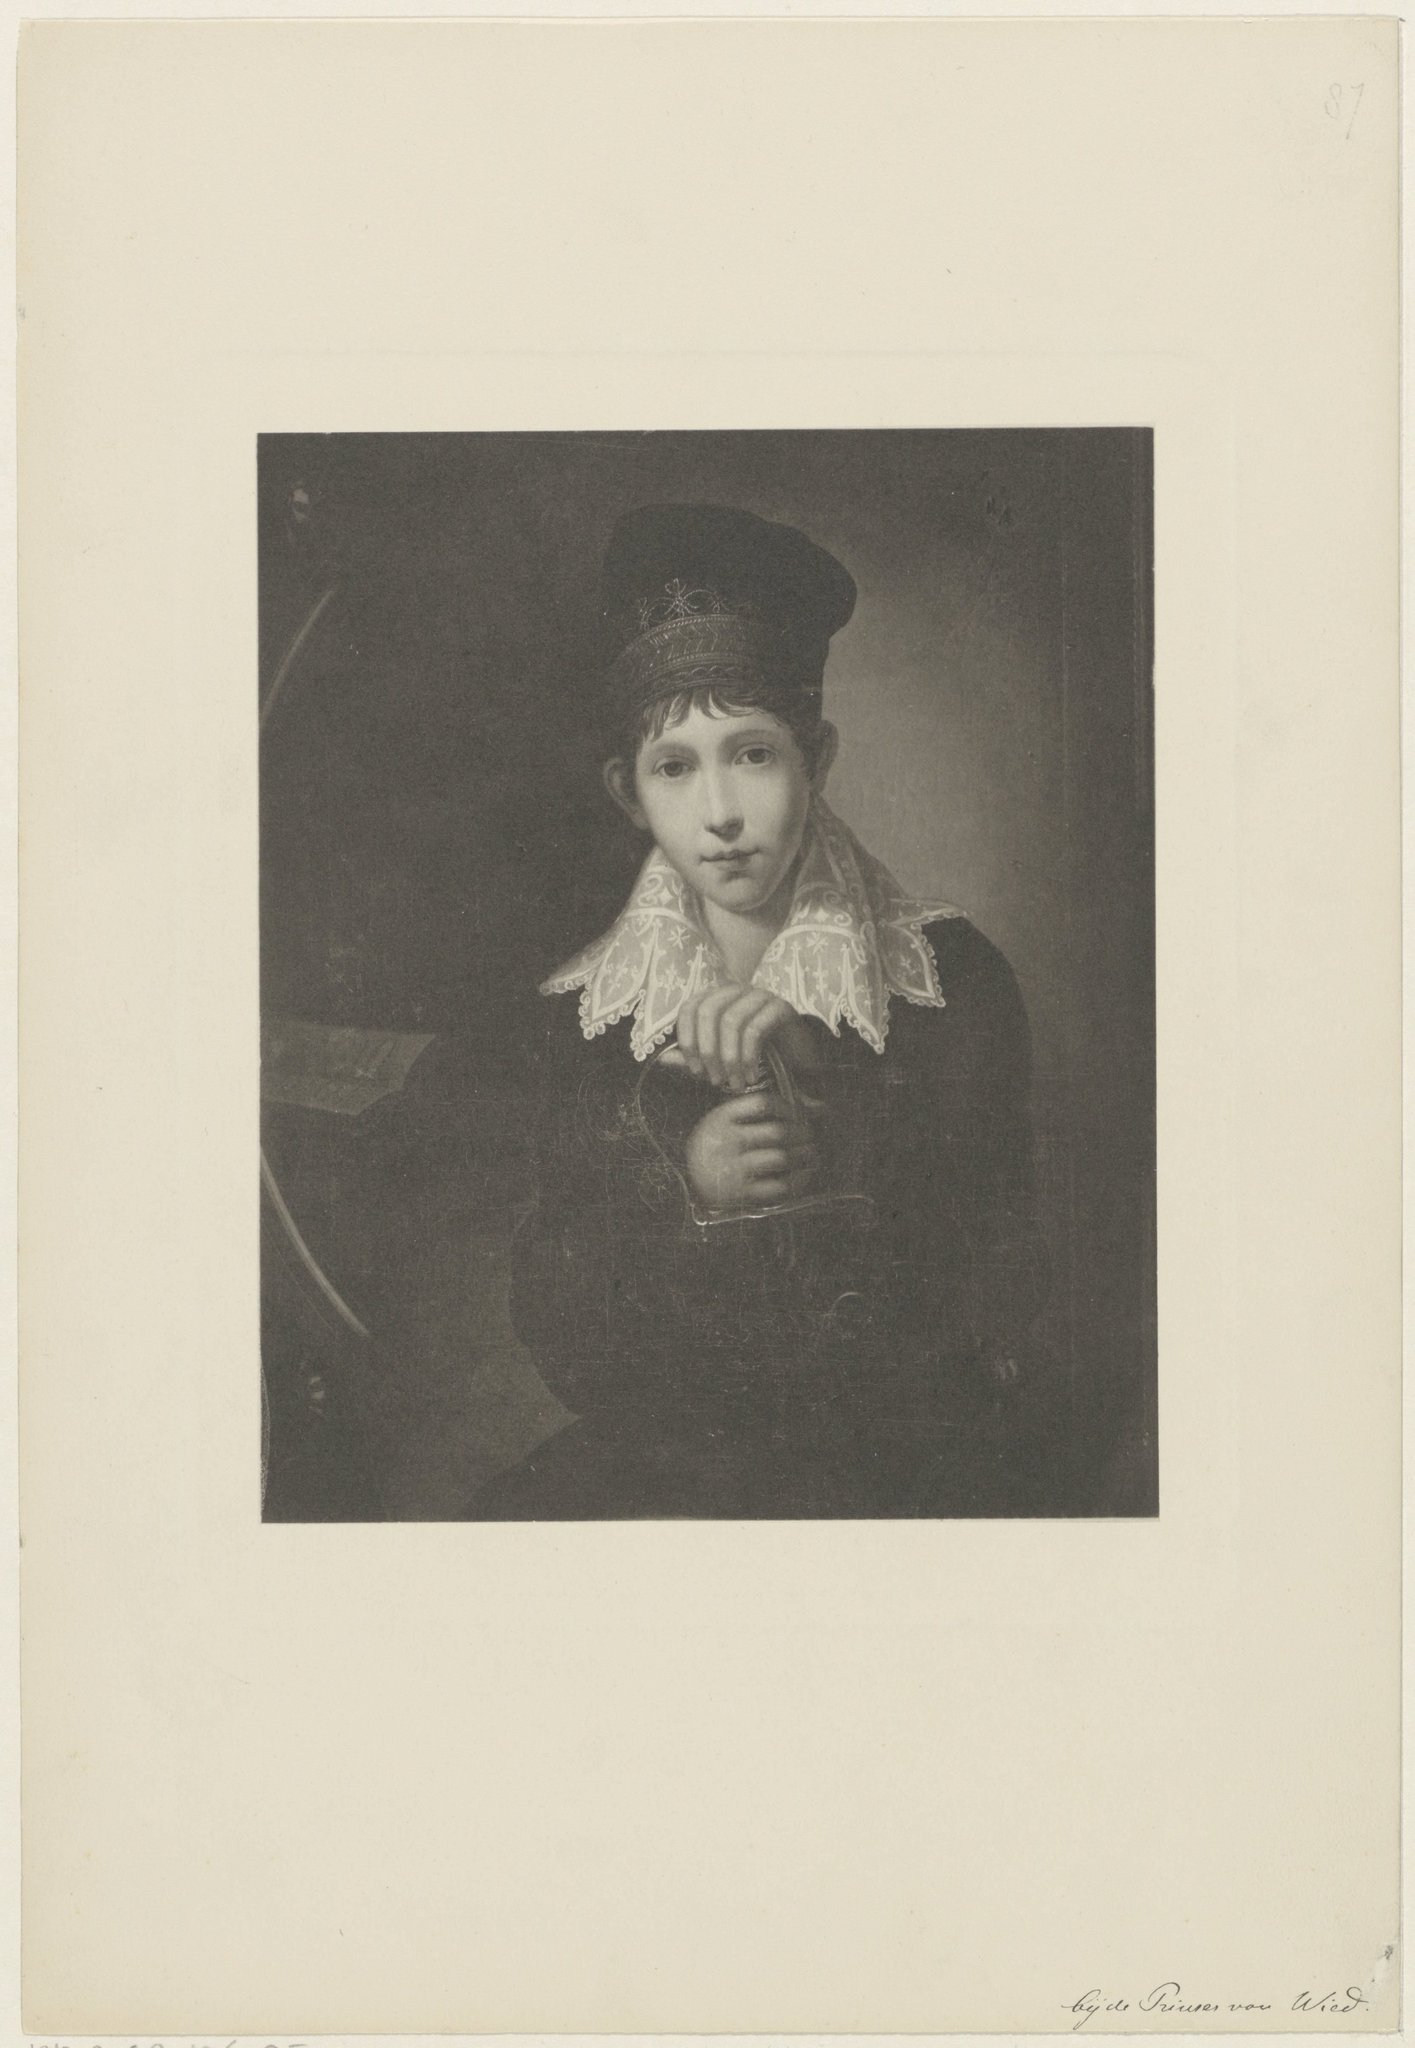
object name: photomechanical print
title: Portret van Frederik, prins der Nederlanden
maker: Anonymous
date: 1850-1949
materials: paper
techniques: photograph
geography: netherlands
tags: berlin, frederik (prins der nederlanden)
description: De hier vermelde titel verwijst naar de hoogst verkregen titel van de geportretteerde, niet per se naar de titel die de geportretteerde op deze voorstelling draagt.